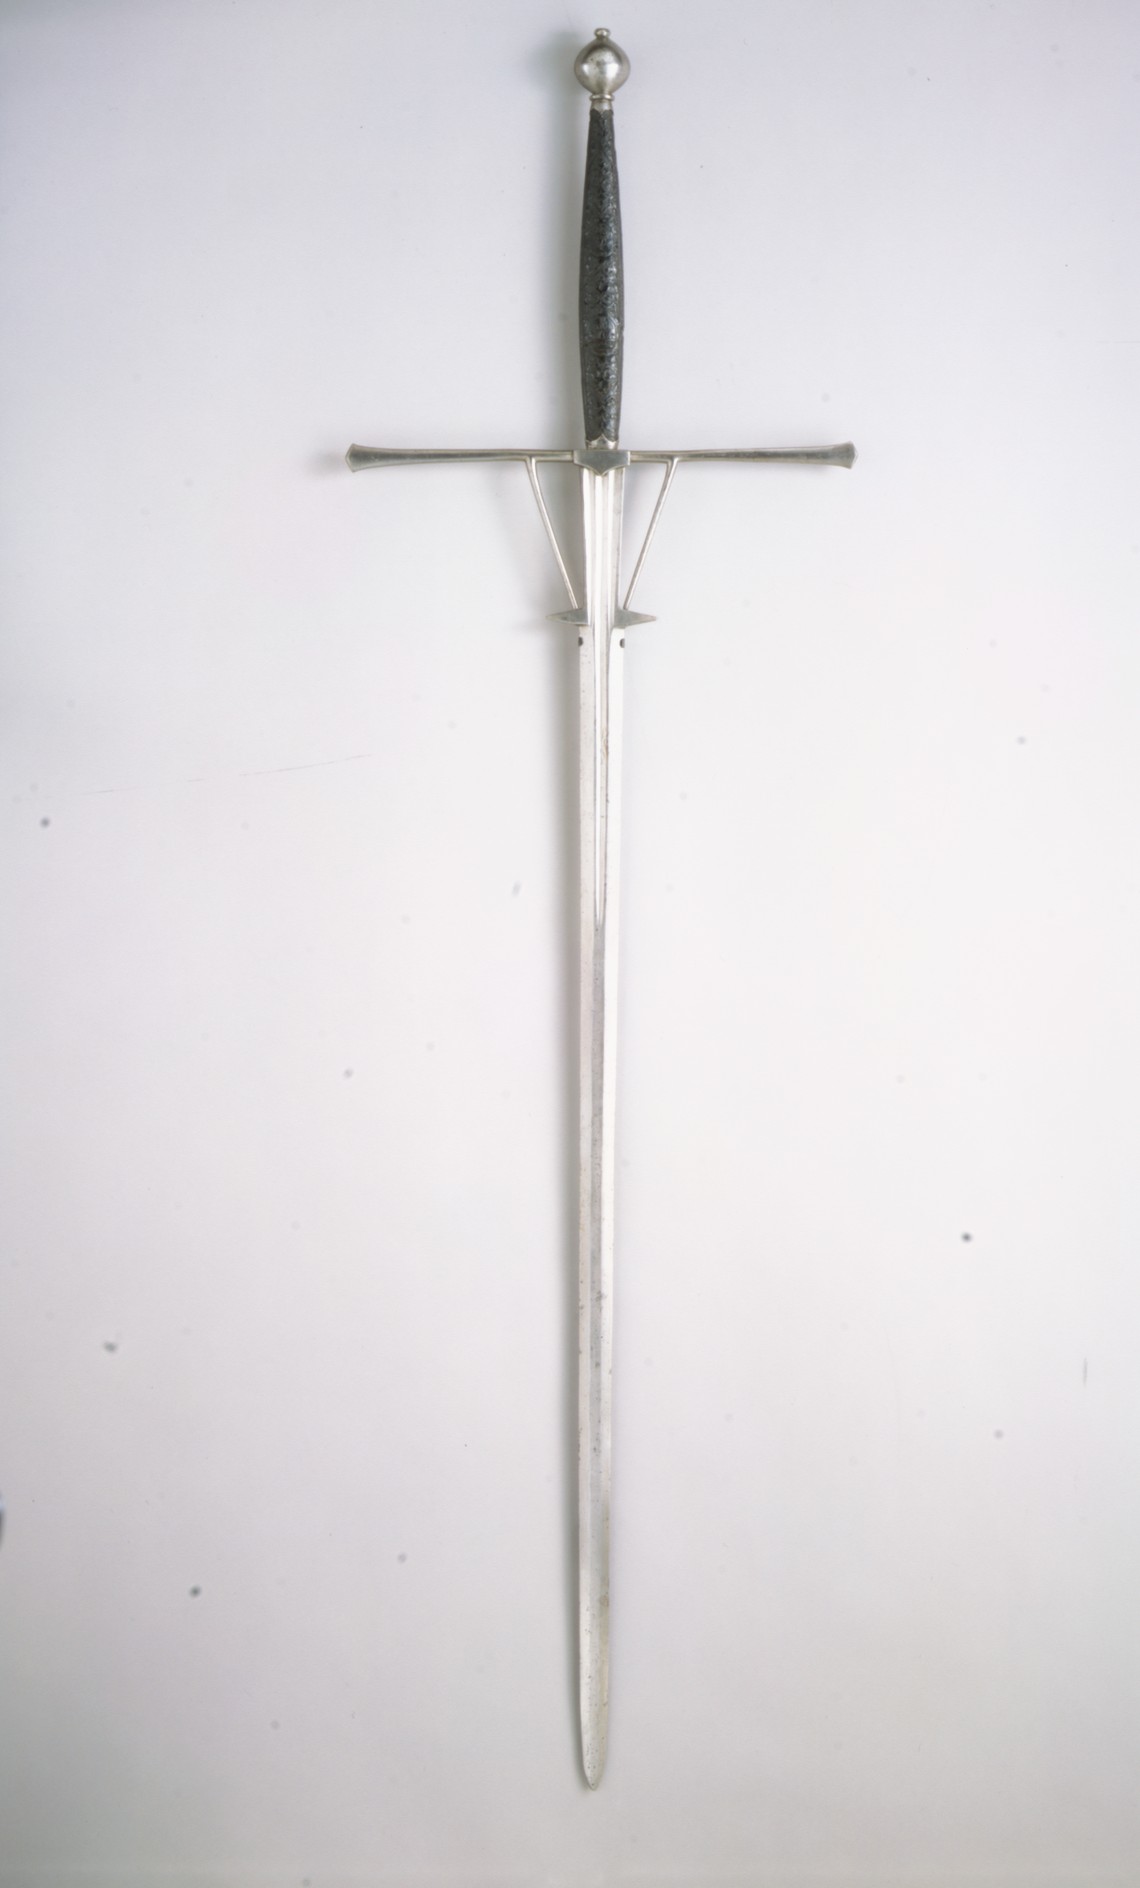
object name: two handed sword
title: Two-Handed Sword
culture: italian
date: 1401-1600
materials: gold, steel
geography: italy